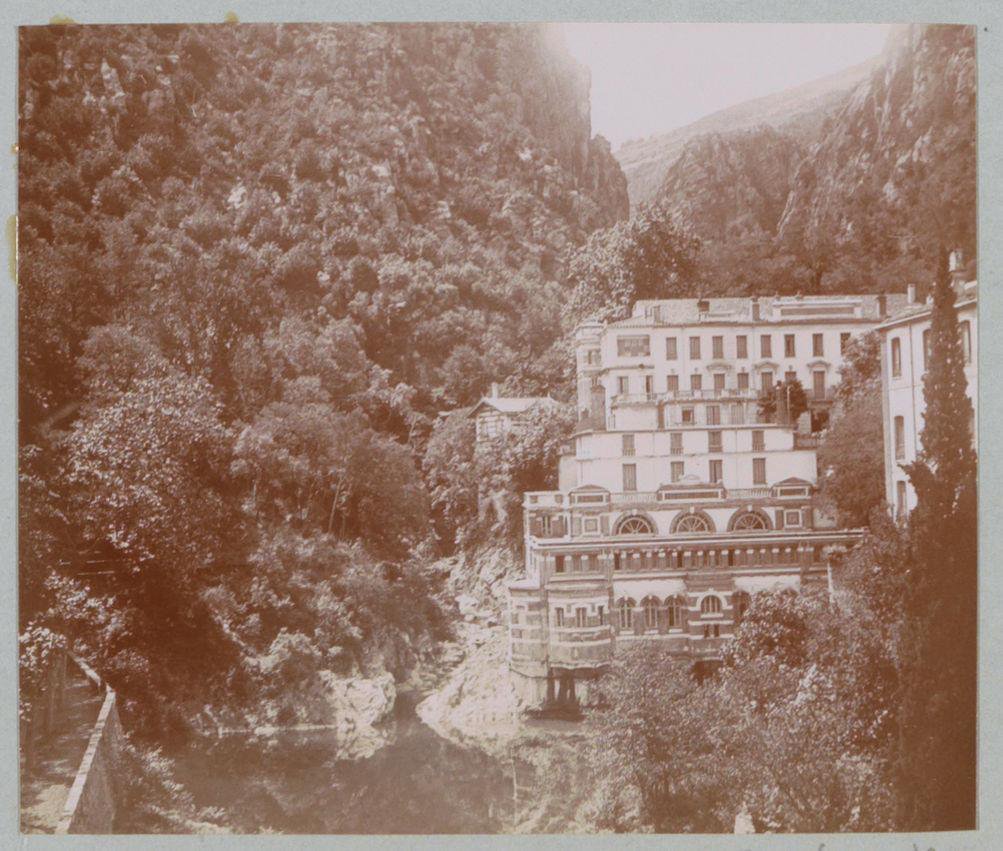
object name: photograph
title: Gezicht op hotel en kuuroord Pujade in Amélie-les-Bains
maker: Anonymous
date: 1905-1910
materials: paper, photographic support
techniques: gelatin silver print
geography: amélie-les-bains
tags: watering-place, spa, mountains (+ landscape with figures, staffage), hotel, hostelry, inn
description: Onderdeel van Fotoalbum van een Franse amateurfotograaf met bezienswaardigheden in Frankrijk, Zwitserland en Italië.